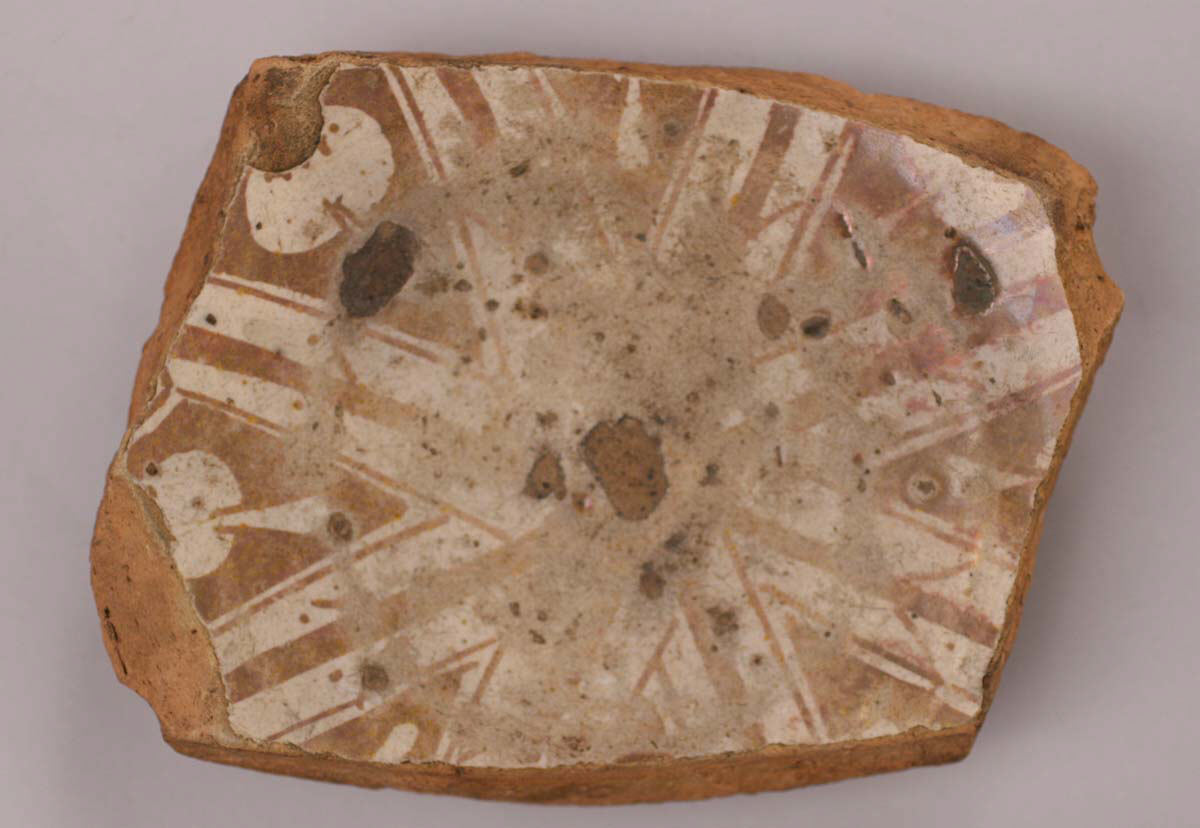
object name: ceramic fragment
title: Luster Ware Fragment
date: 1401-1500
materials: earthenware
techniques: glazing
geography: spain